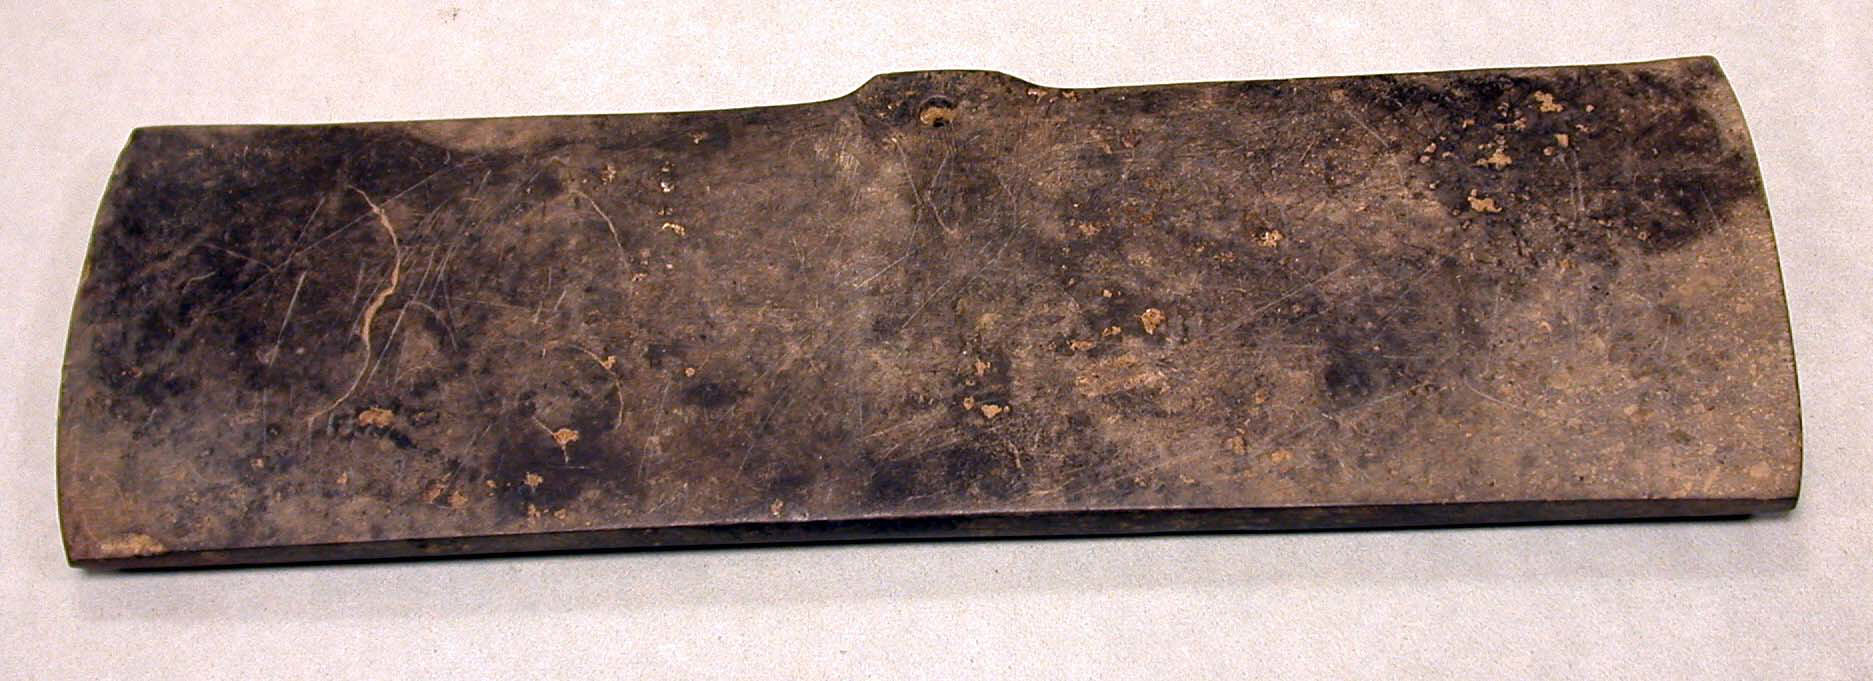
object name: pendant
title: Winged Pendant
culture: tairona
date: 1501-1600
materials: stone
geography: colombia